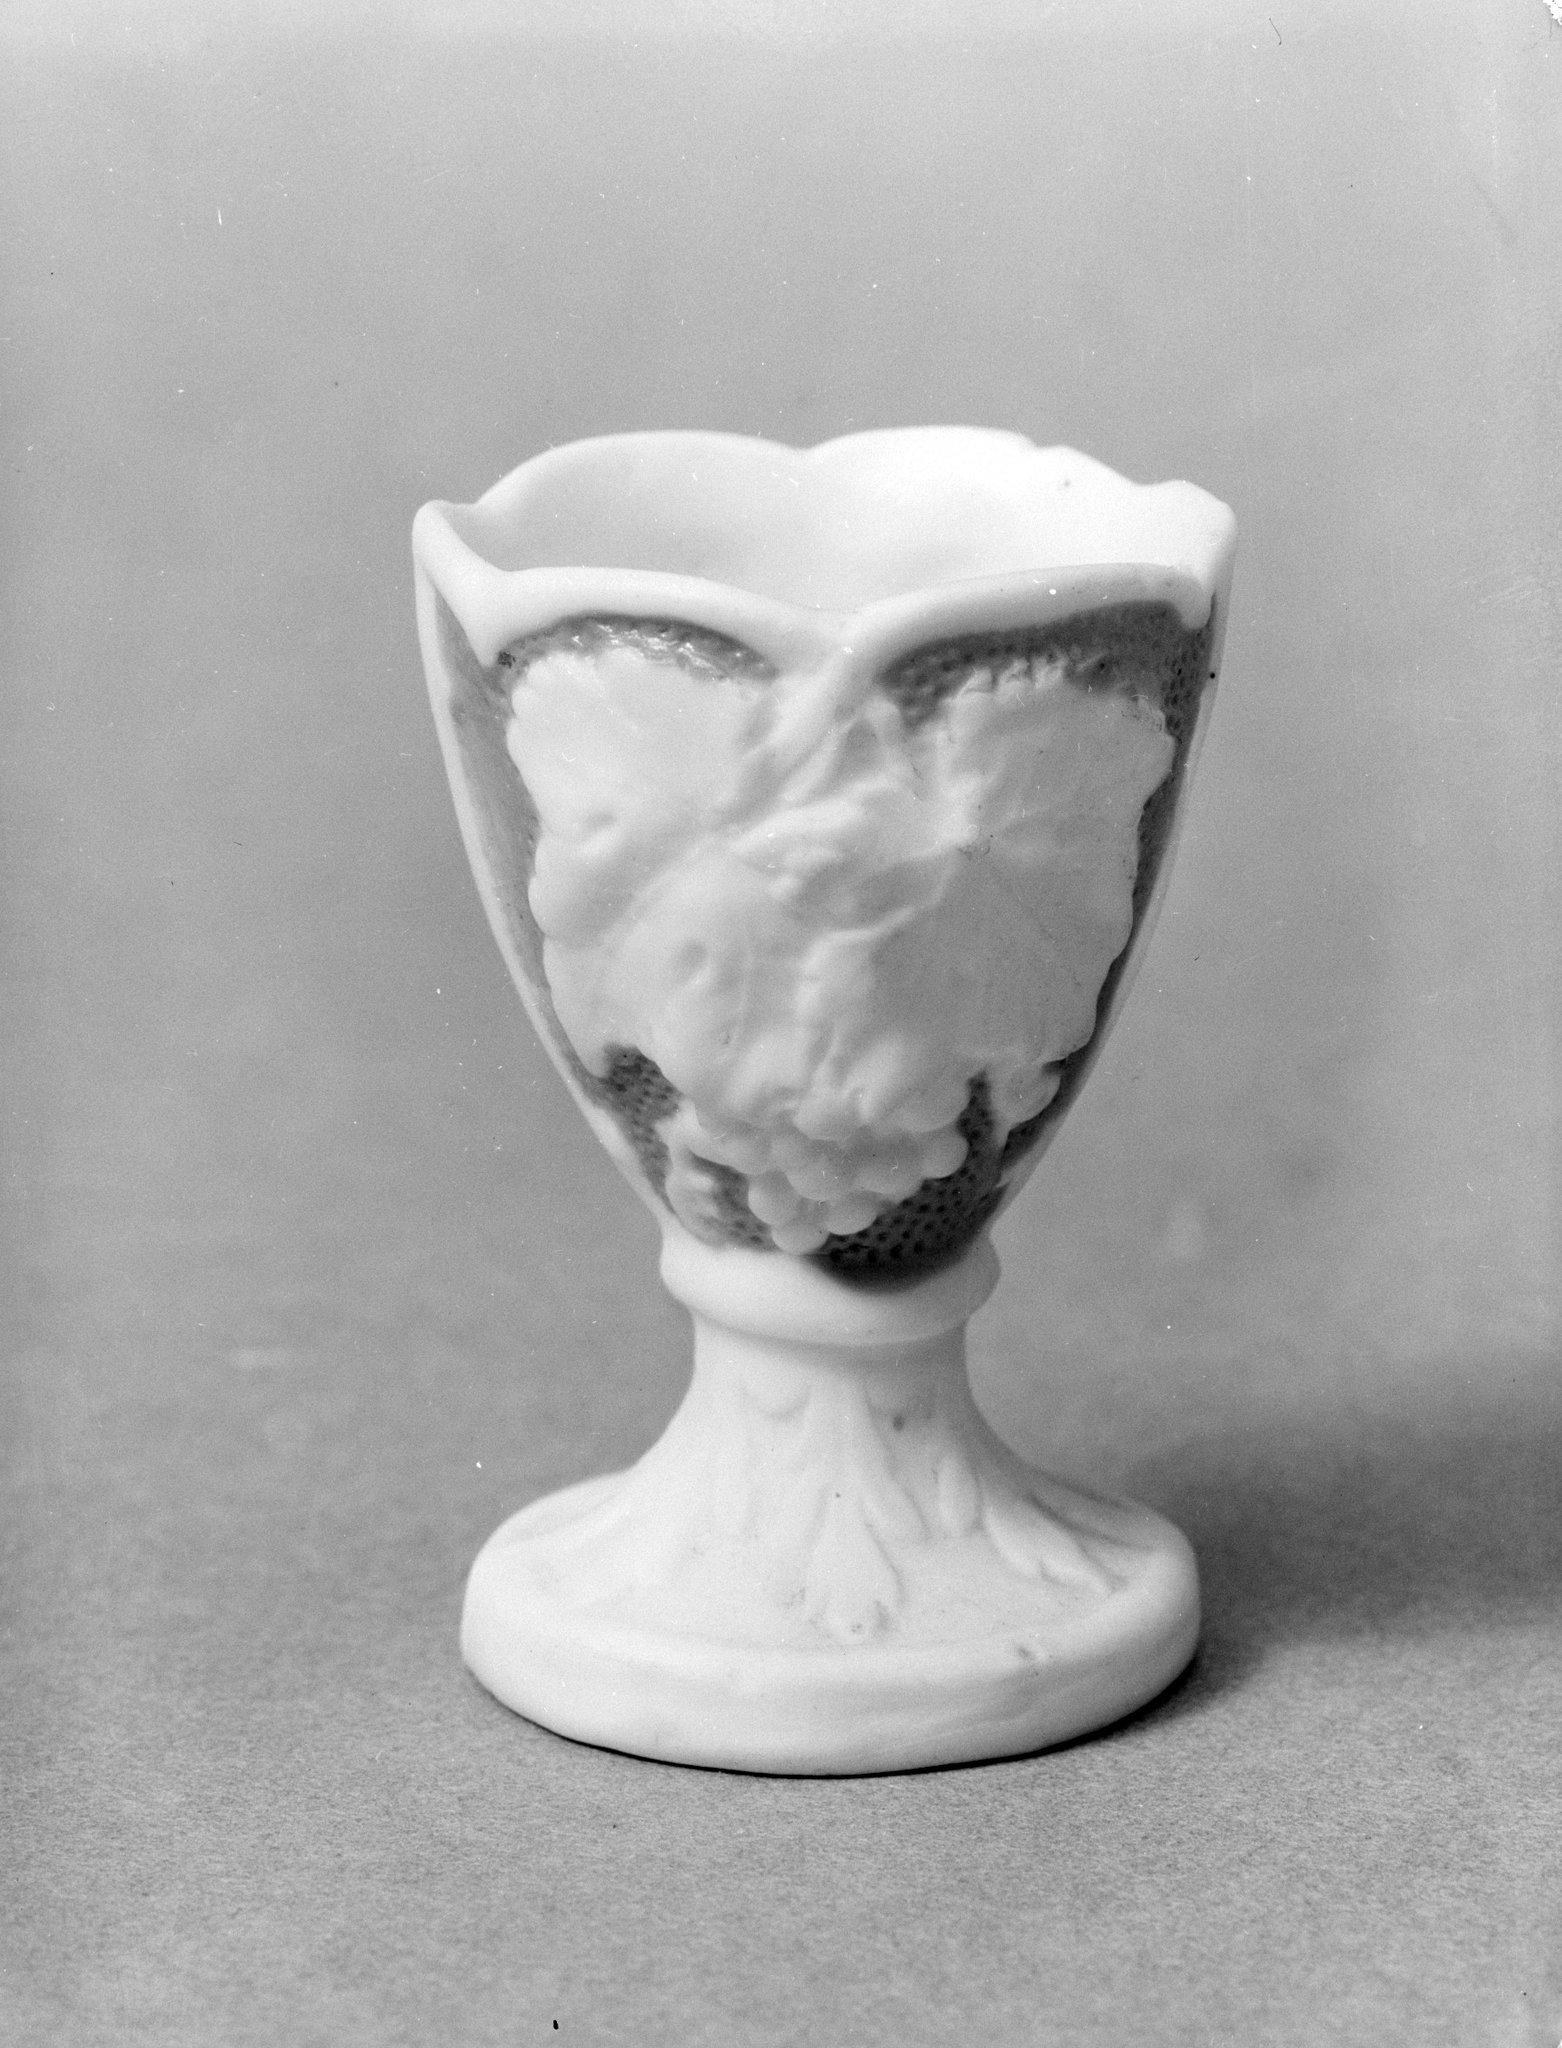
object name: egg cup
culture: american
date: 1830-1870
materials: porcelain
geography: united states